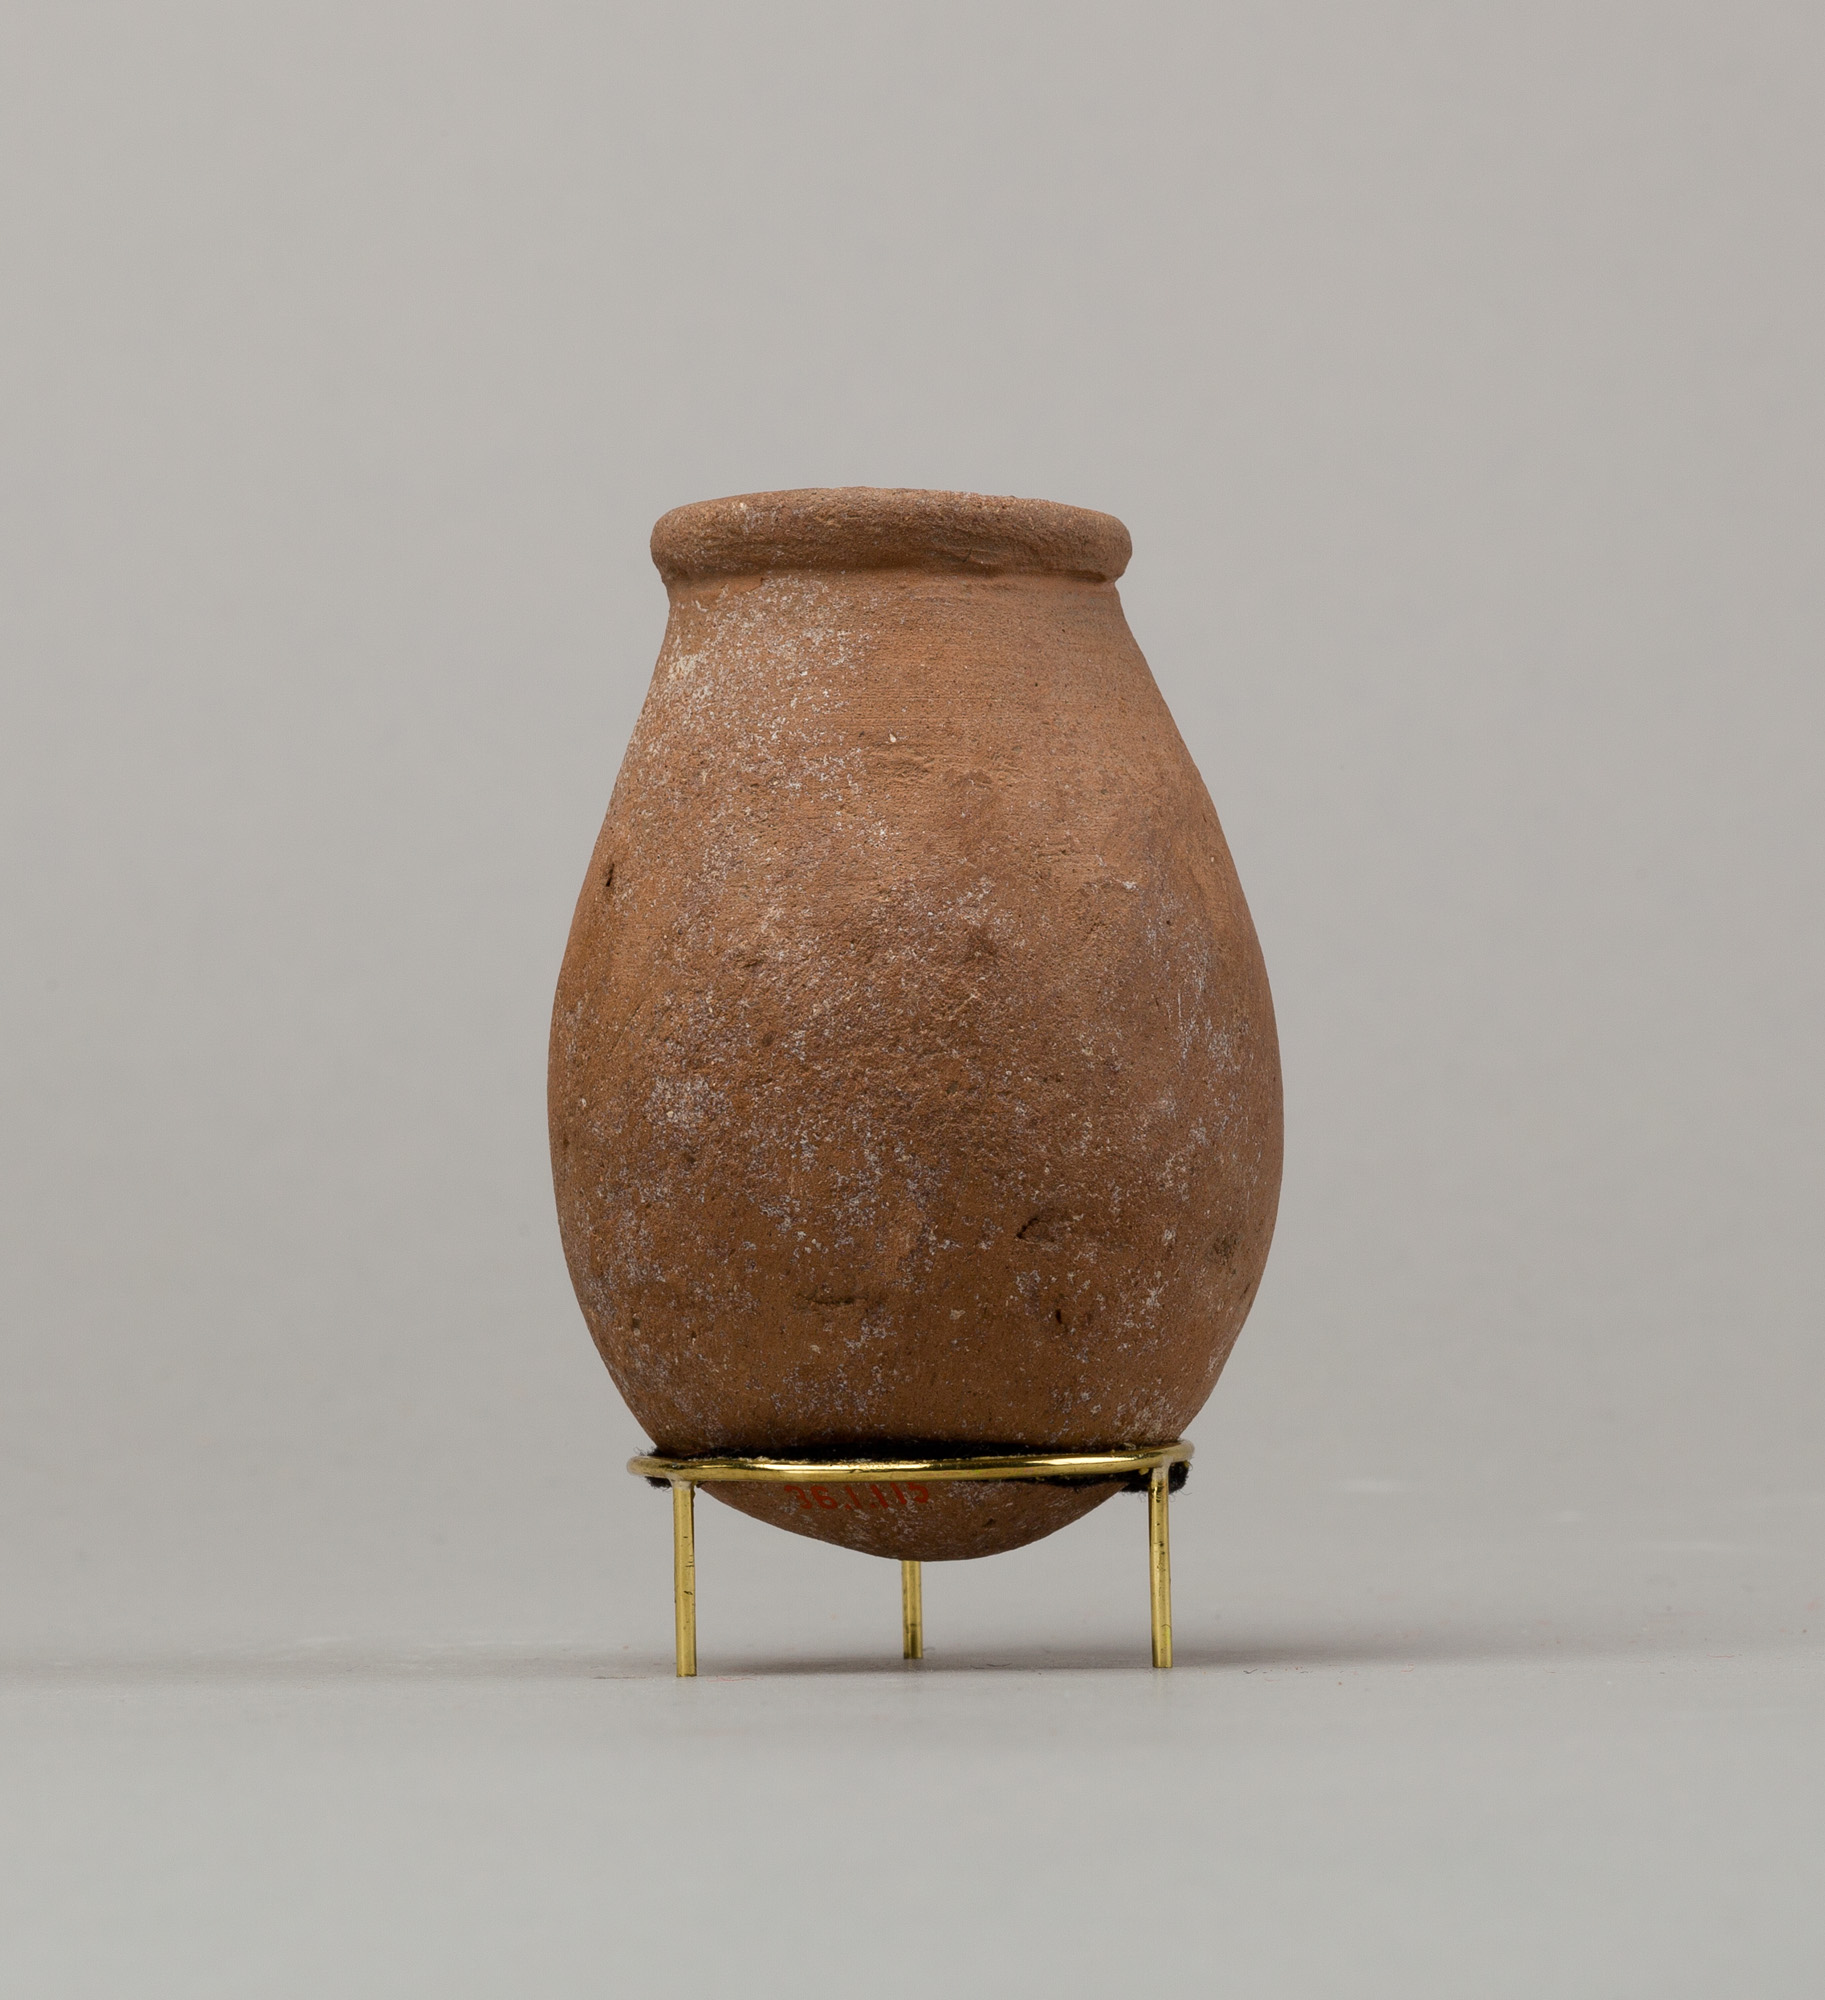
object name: jar, rough ware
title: Rough ware jar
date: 3850-2960 BCE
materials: pottery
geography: egypt